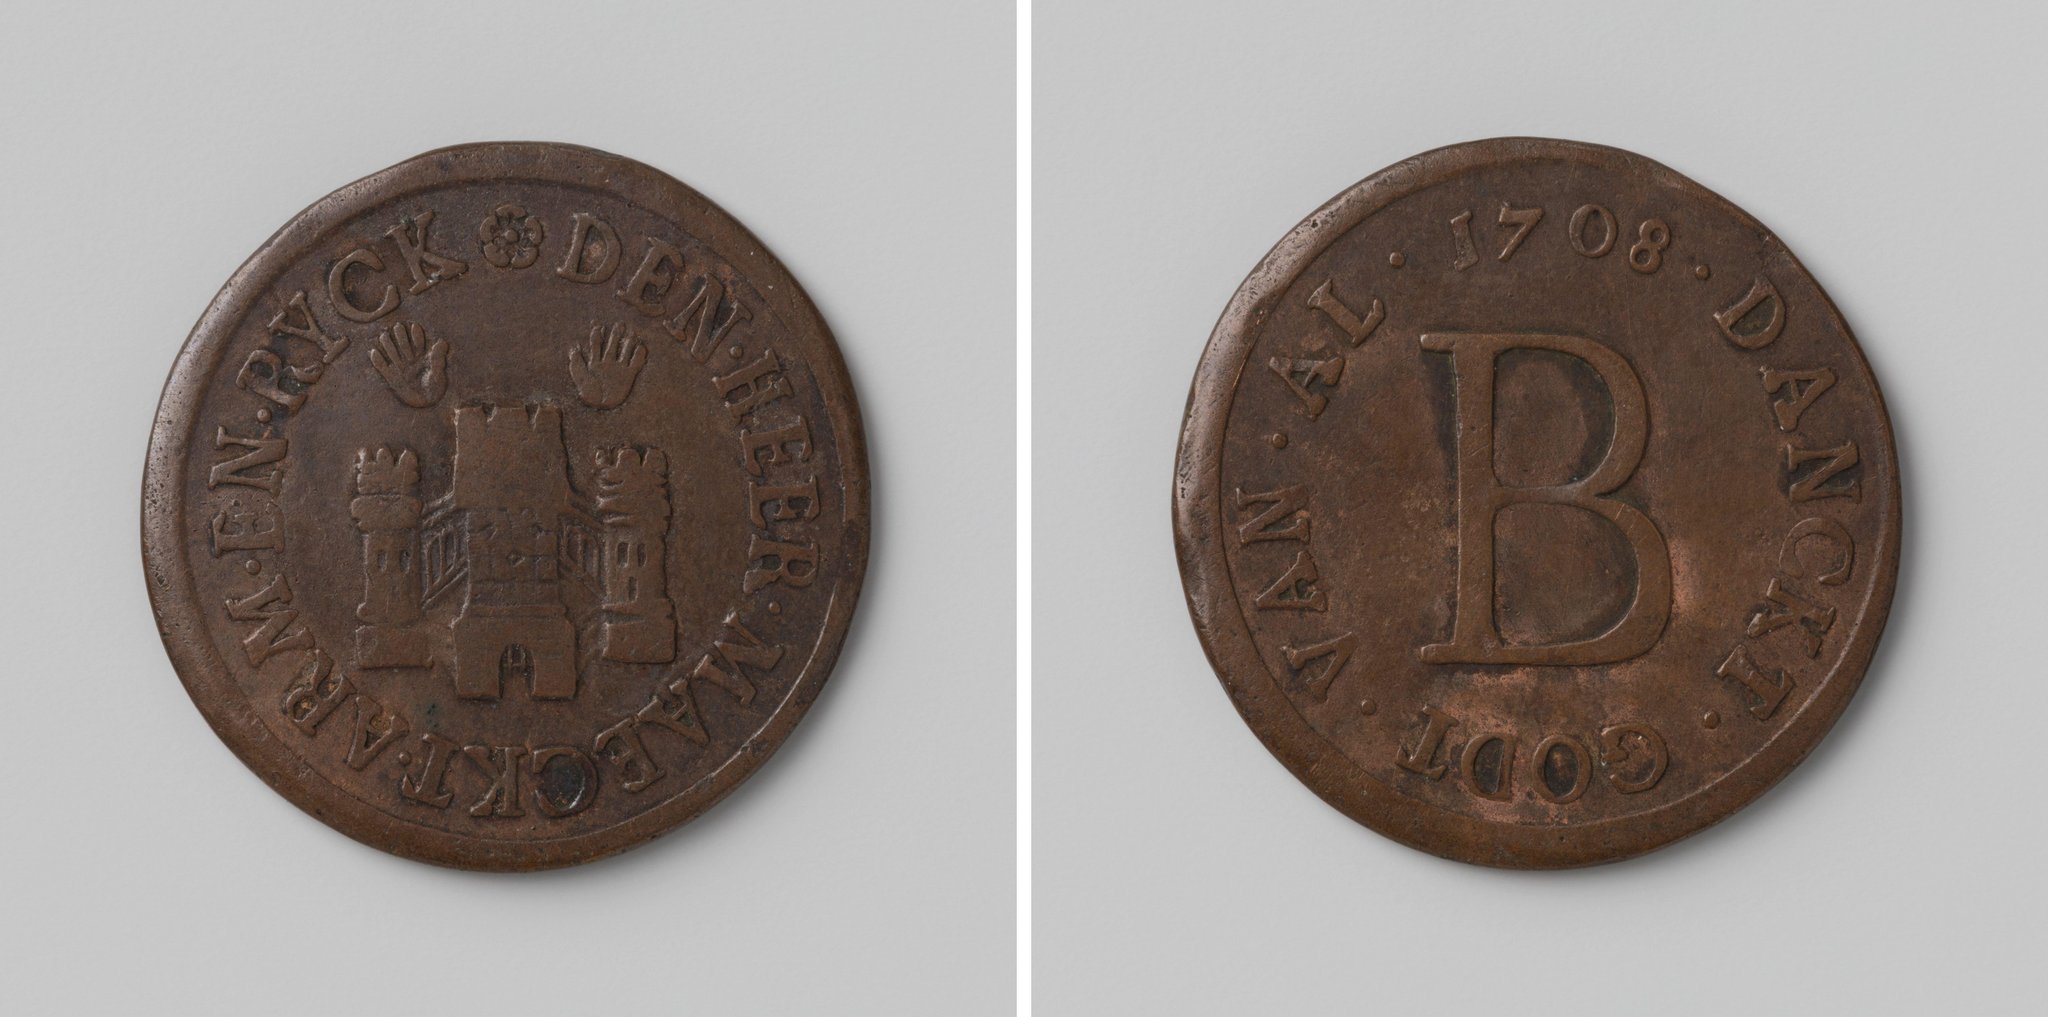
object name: armenloodje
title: Stad Antwerpen, loodje dat bij uitdeling recht gaf op brood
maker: Anonymous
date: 1708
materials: copper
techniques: striking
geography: antwerp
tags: antwerp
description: Koperen penning. Voorzijde: twee geopende handen boven burcht binnen omschrift. Keerzijde: letter B binnen omschrift